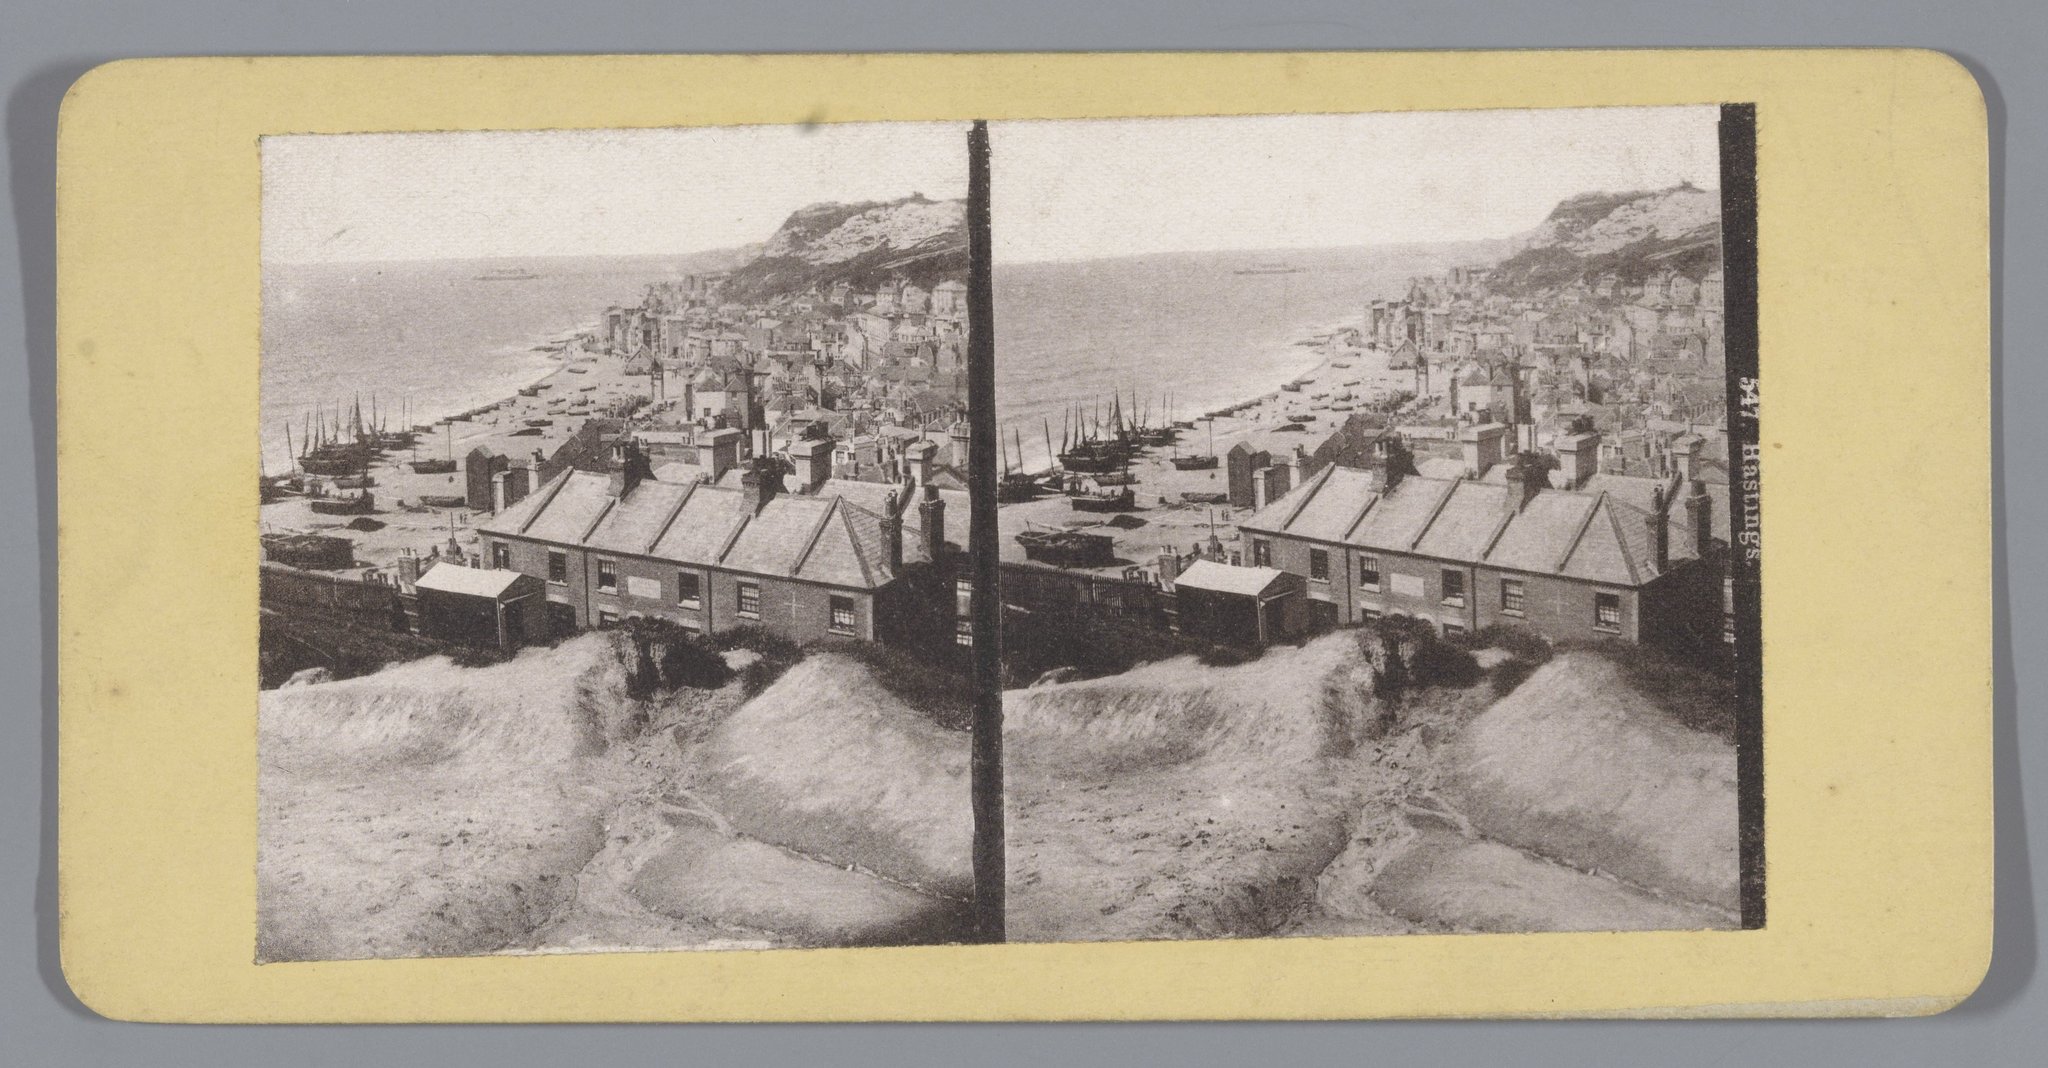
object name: stereograph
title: Gezicht op Hastings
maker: Anonymous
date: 1890-1910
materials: cardboard, paper, ink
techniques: photograph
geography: hastings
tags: city-view in general; 'veduta'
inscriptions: number: ‘547.’